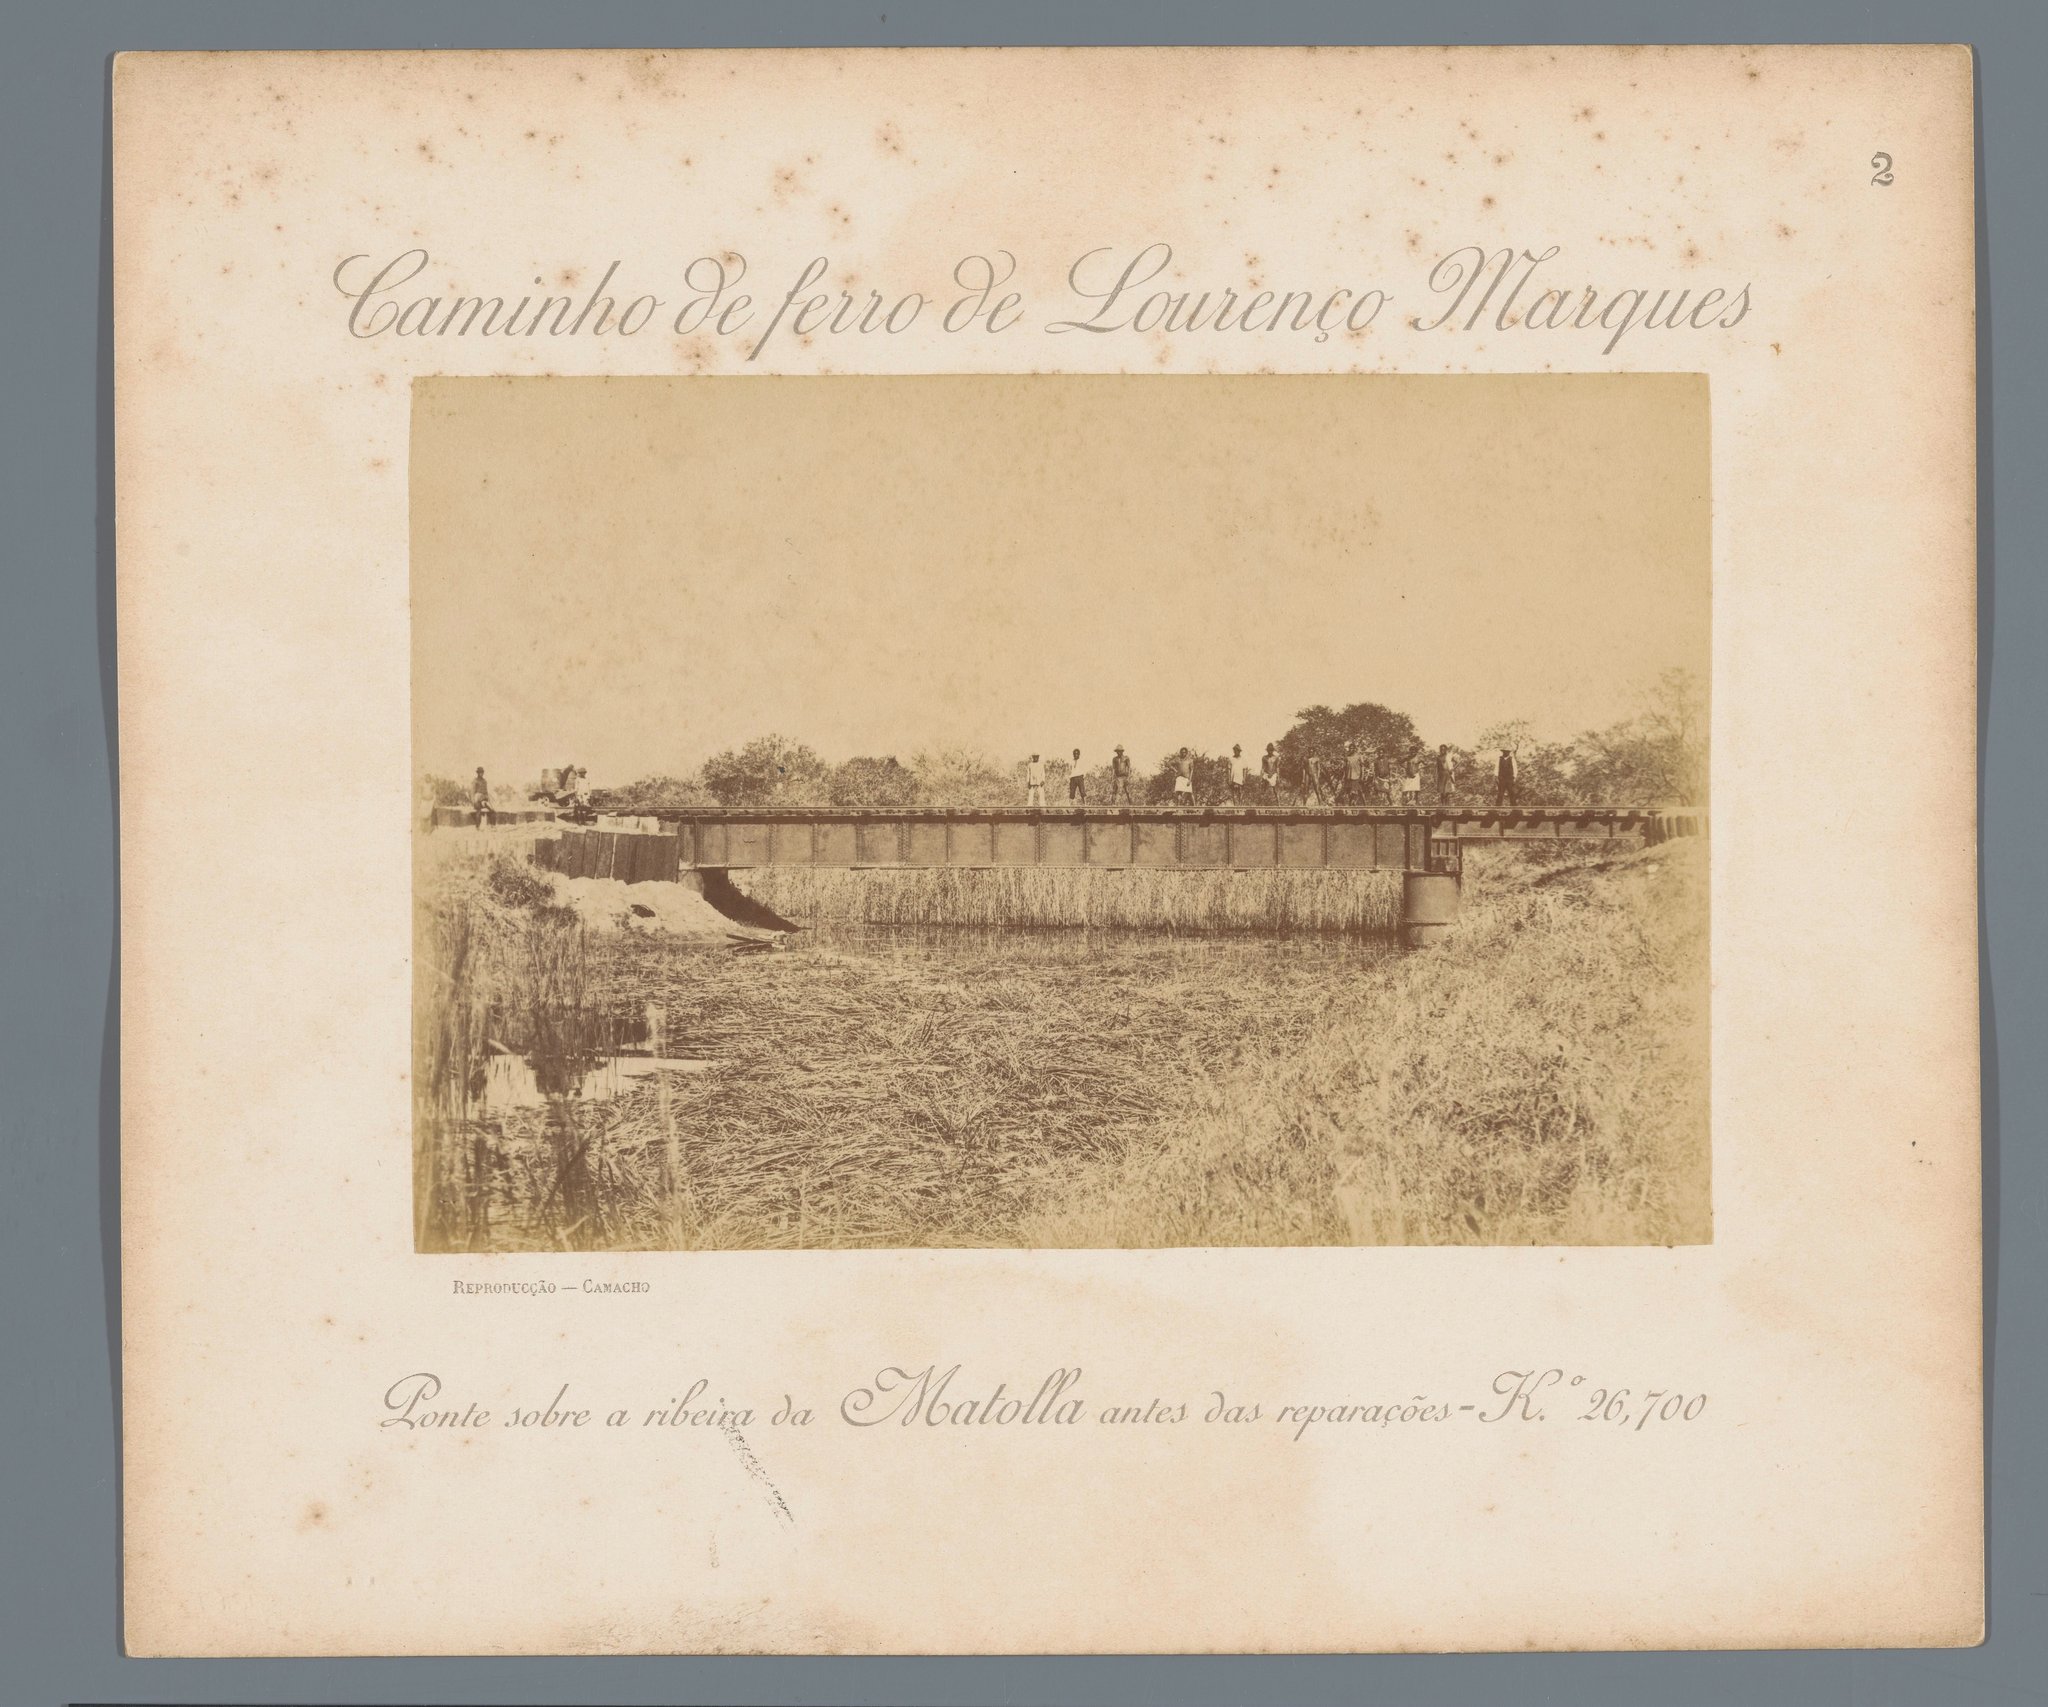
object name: photograph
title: Ponte sobre a ribeira da Matolla antes das reparações-K. 26,700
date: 1886-1895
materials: photographic support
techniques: albumen print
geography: lisbon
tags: landscape with bridge, viaduct or aqueduct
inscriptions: number: ‘2’